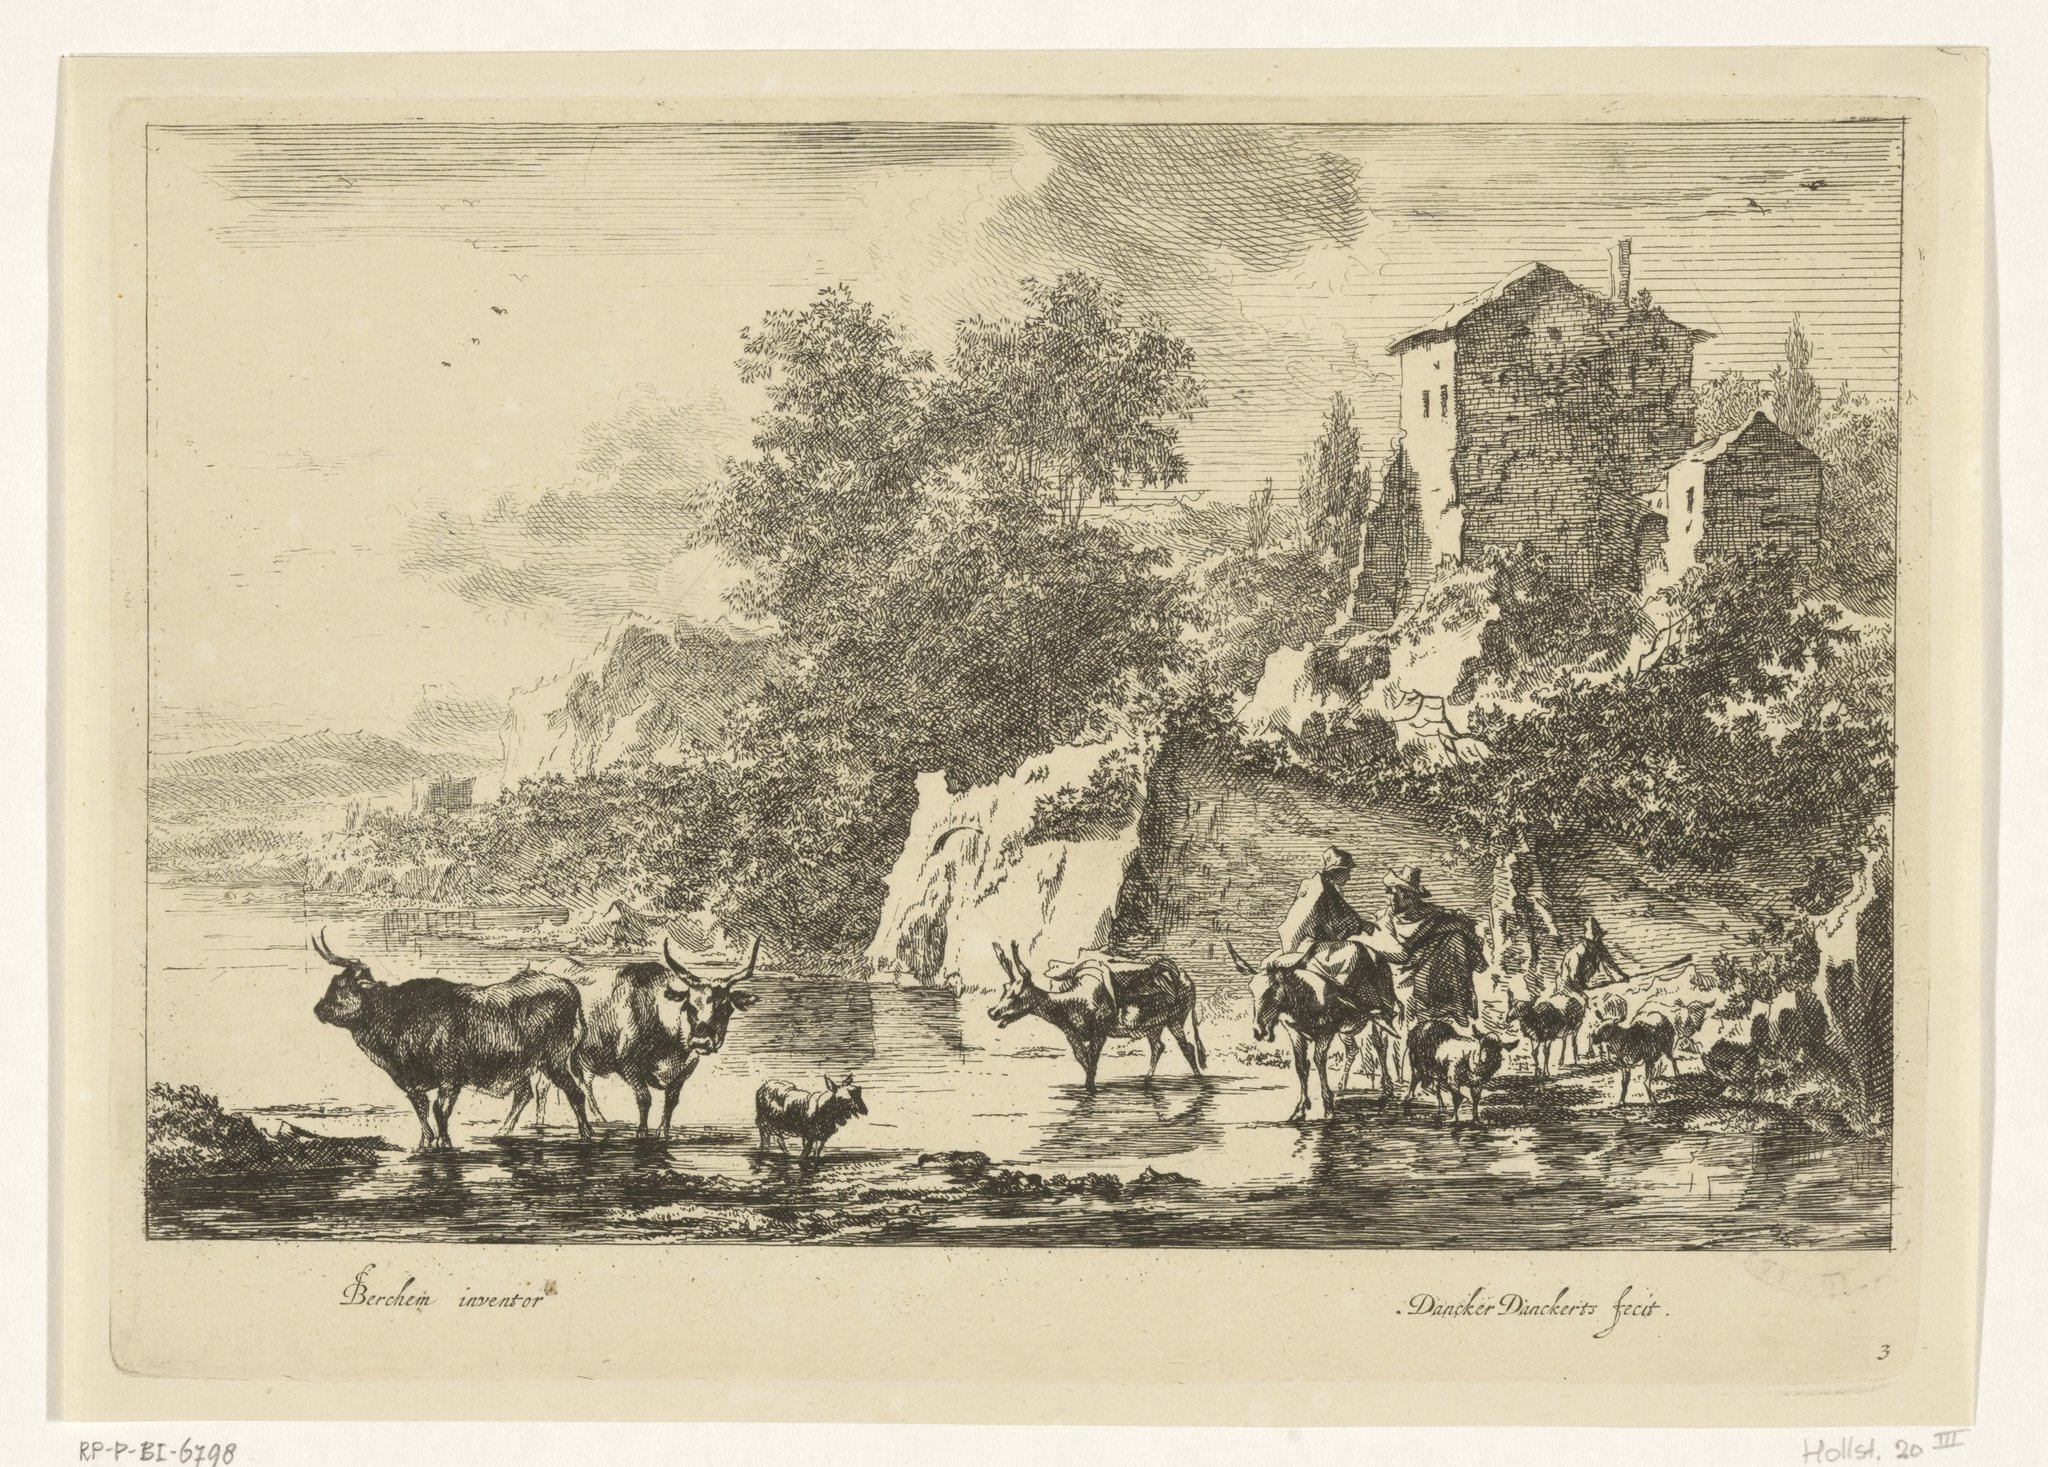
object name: print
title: Italiaanse landschappen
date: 1643-1666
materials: paper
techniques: etching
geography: amsterdam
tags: herding, herdsman, herdswoman, shepherd, shepherdess, cowherd, etc., rocks, herd, flock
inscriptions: collector's mark: Lugt 240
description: Prent uit serie van zes landschappen naar ontwerp van Pieter Nicolaesz. Berchem.